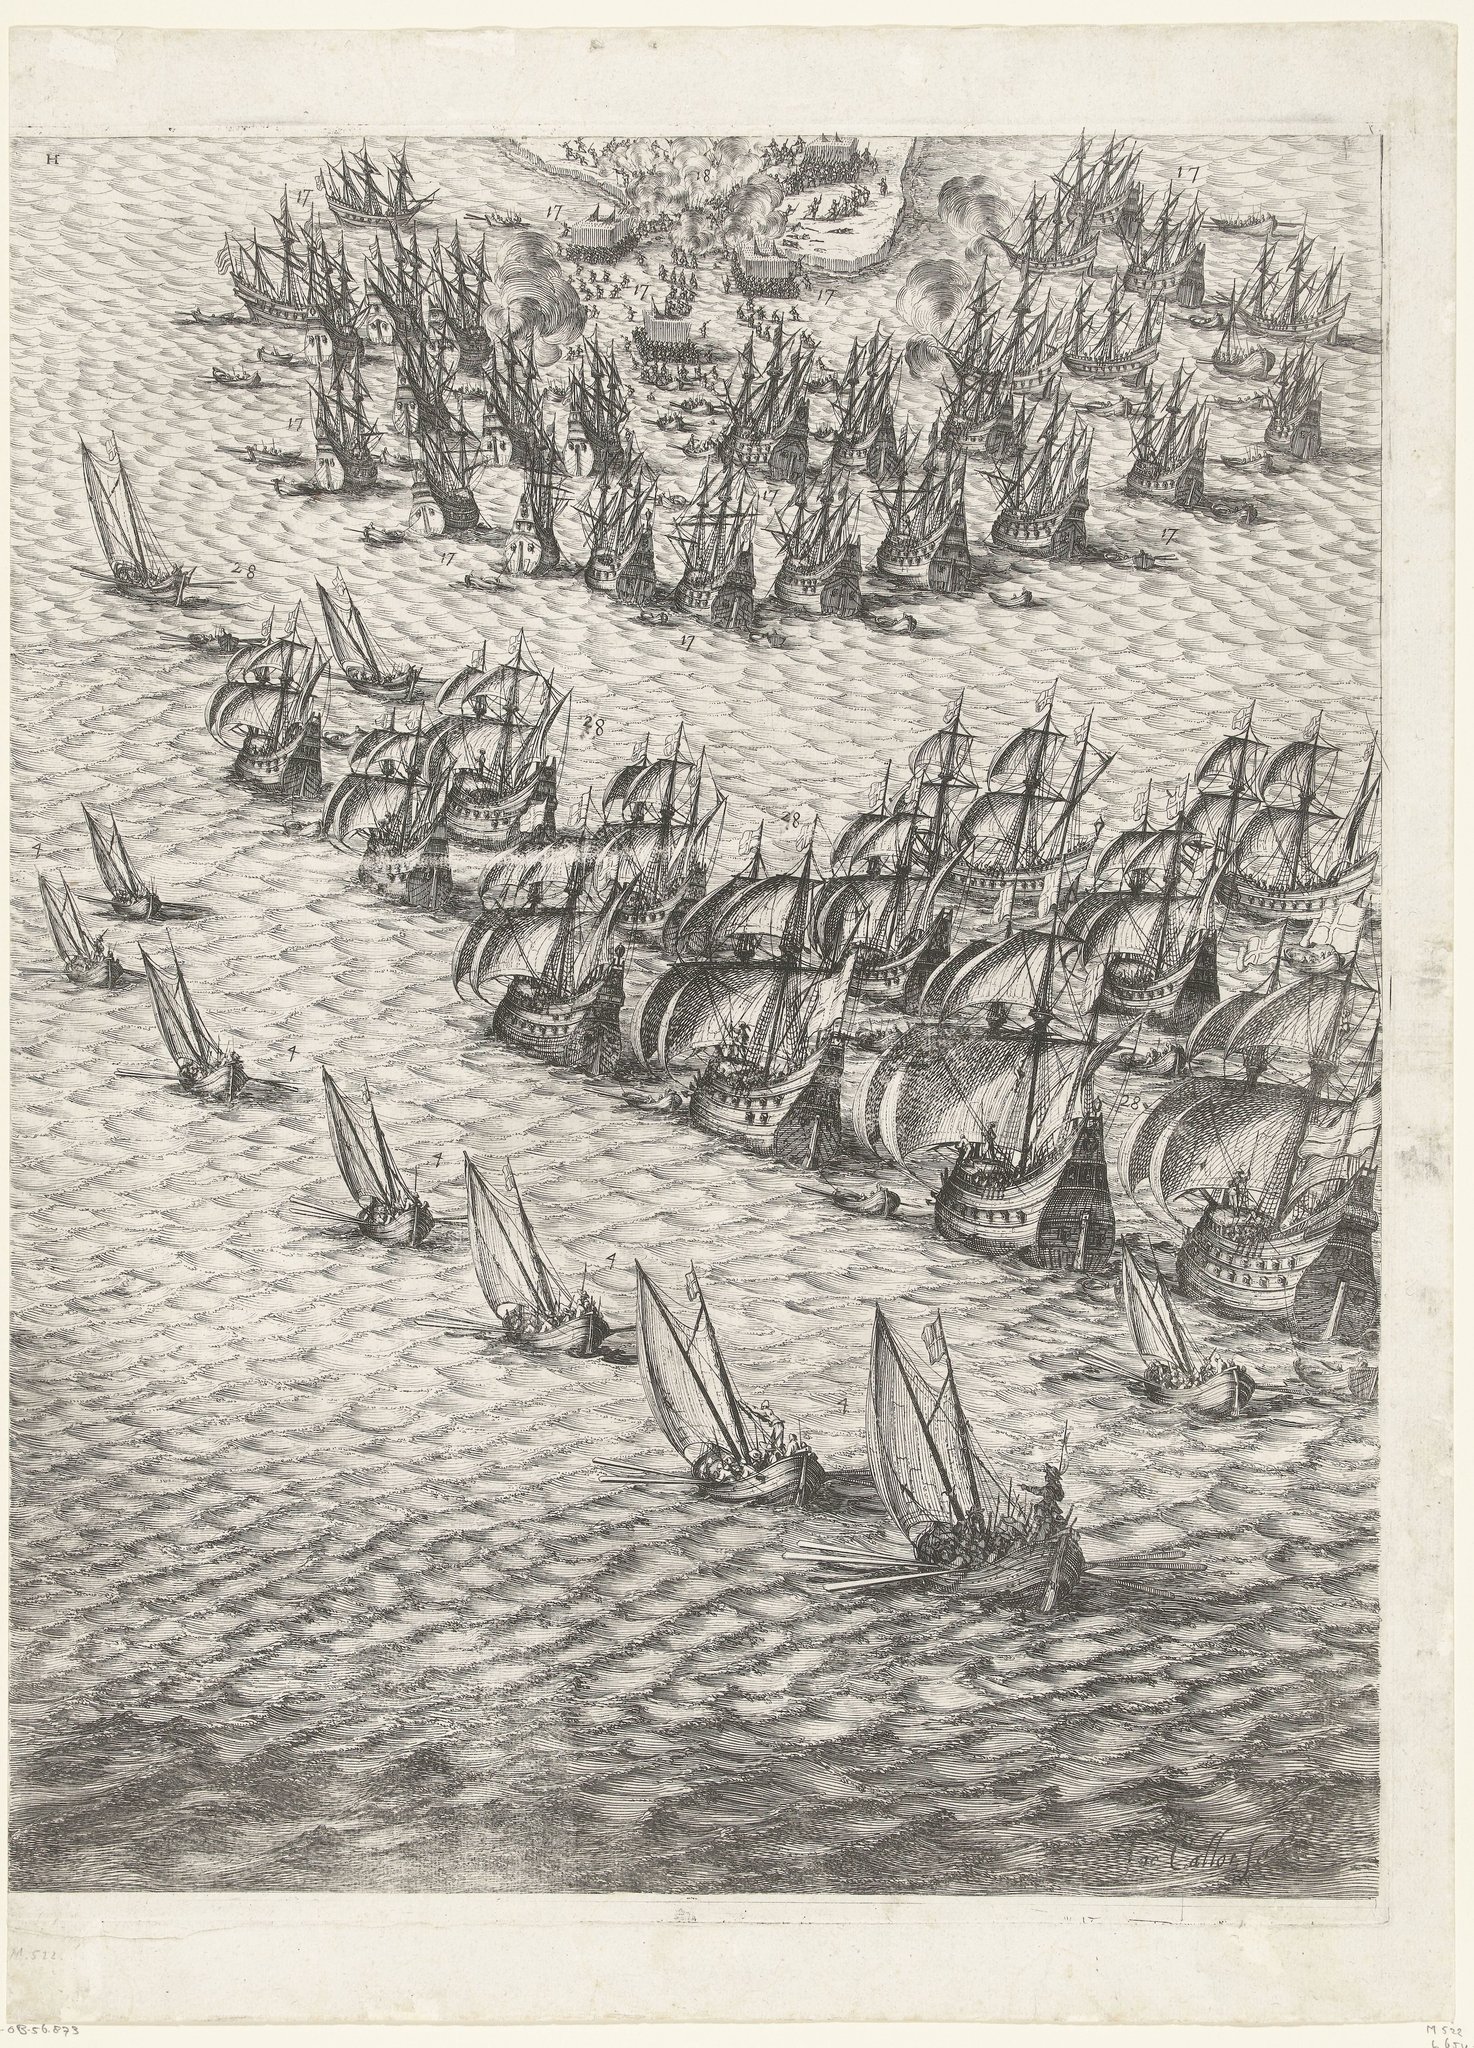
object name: history print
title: Beleg van Saint Martin op het Île de Ré, juli-november 1627 (centrale kaart, deel rechtsonder)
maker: jacques callot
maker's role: draughtsman, print maker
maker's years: 1592-1635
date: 1629-1631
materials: paper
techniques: etching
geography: paris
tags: maps of separate countries or regions, battle, ships (in general), warfare; military affairs (+ naval force), siege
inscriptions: collector's mark: Lugt 240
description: Zestiende deel (centrale kaart, deel rechtsonder) van een prent van het beleg van de citadel Saint Martin op het Île de Ré in 1627, dat werd uitgevoerd door Engelse troepen onder leiding van de hertog van Buckingham en werd beëindigd door Franse troepen onder leiding van kardinaal Richelieu. Op dit blad een klein stukje van de westelijke punt van het eiland, waar Franse troepen landen vanuit zee. Horizontaal over het blad een vloot Engelse schepen en een kleiner groepje Franse bevoorradingsboten.